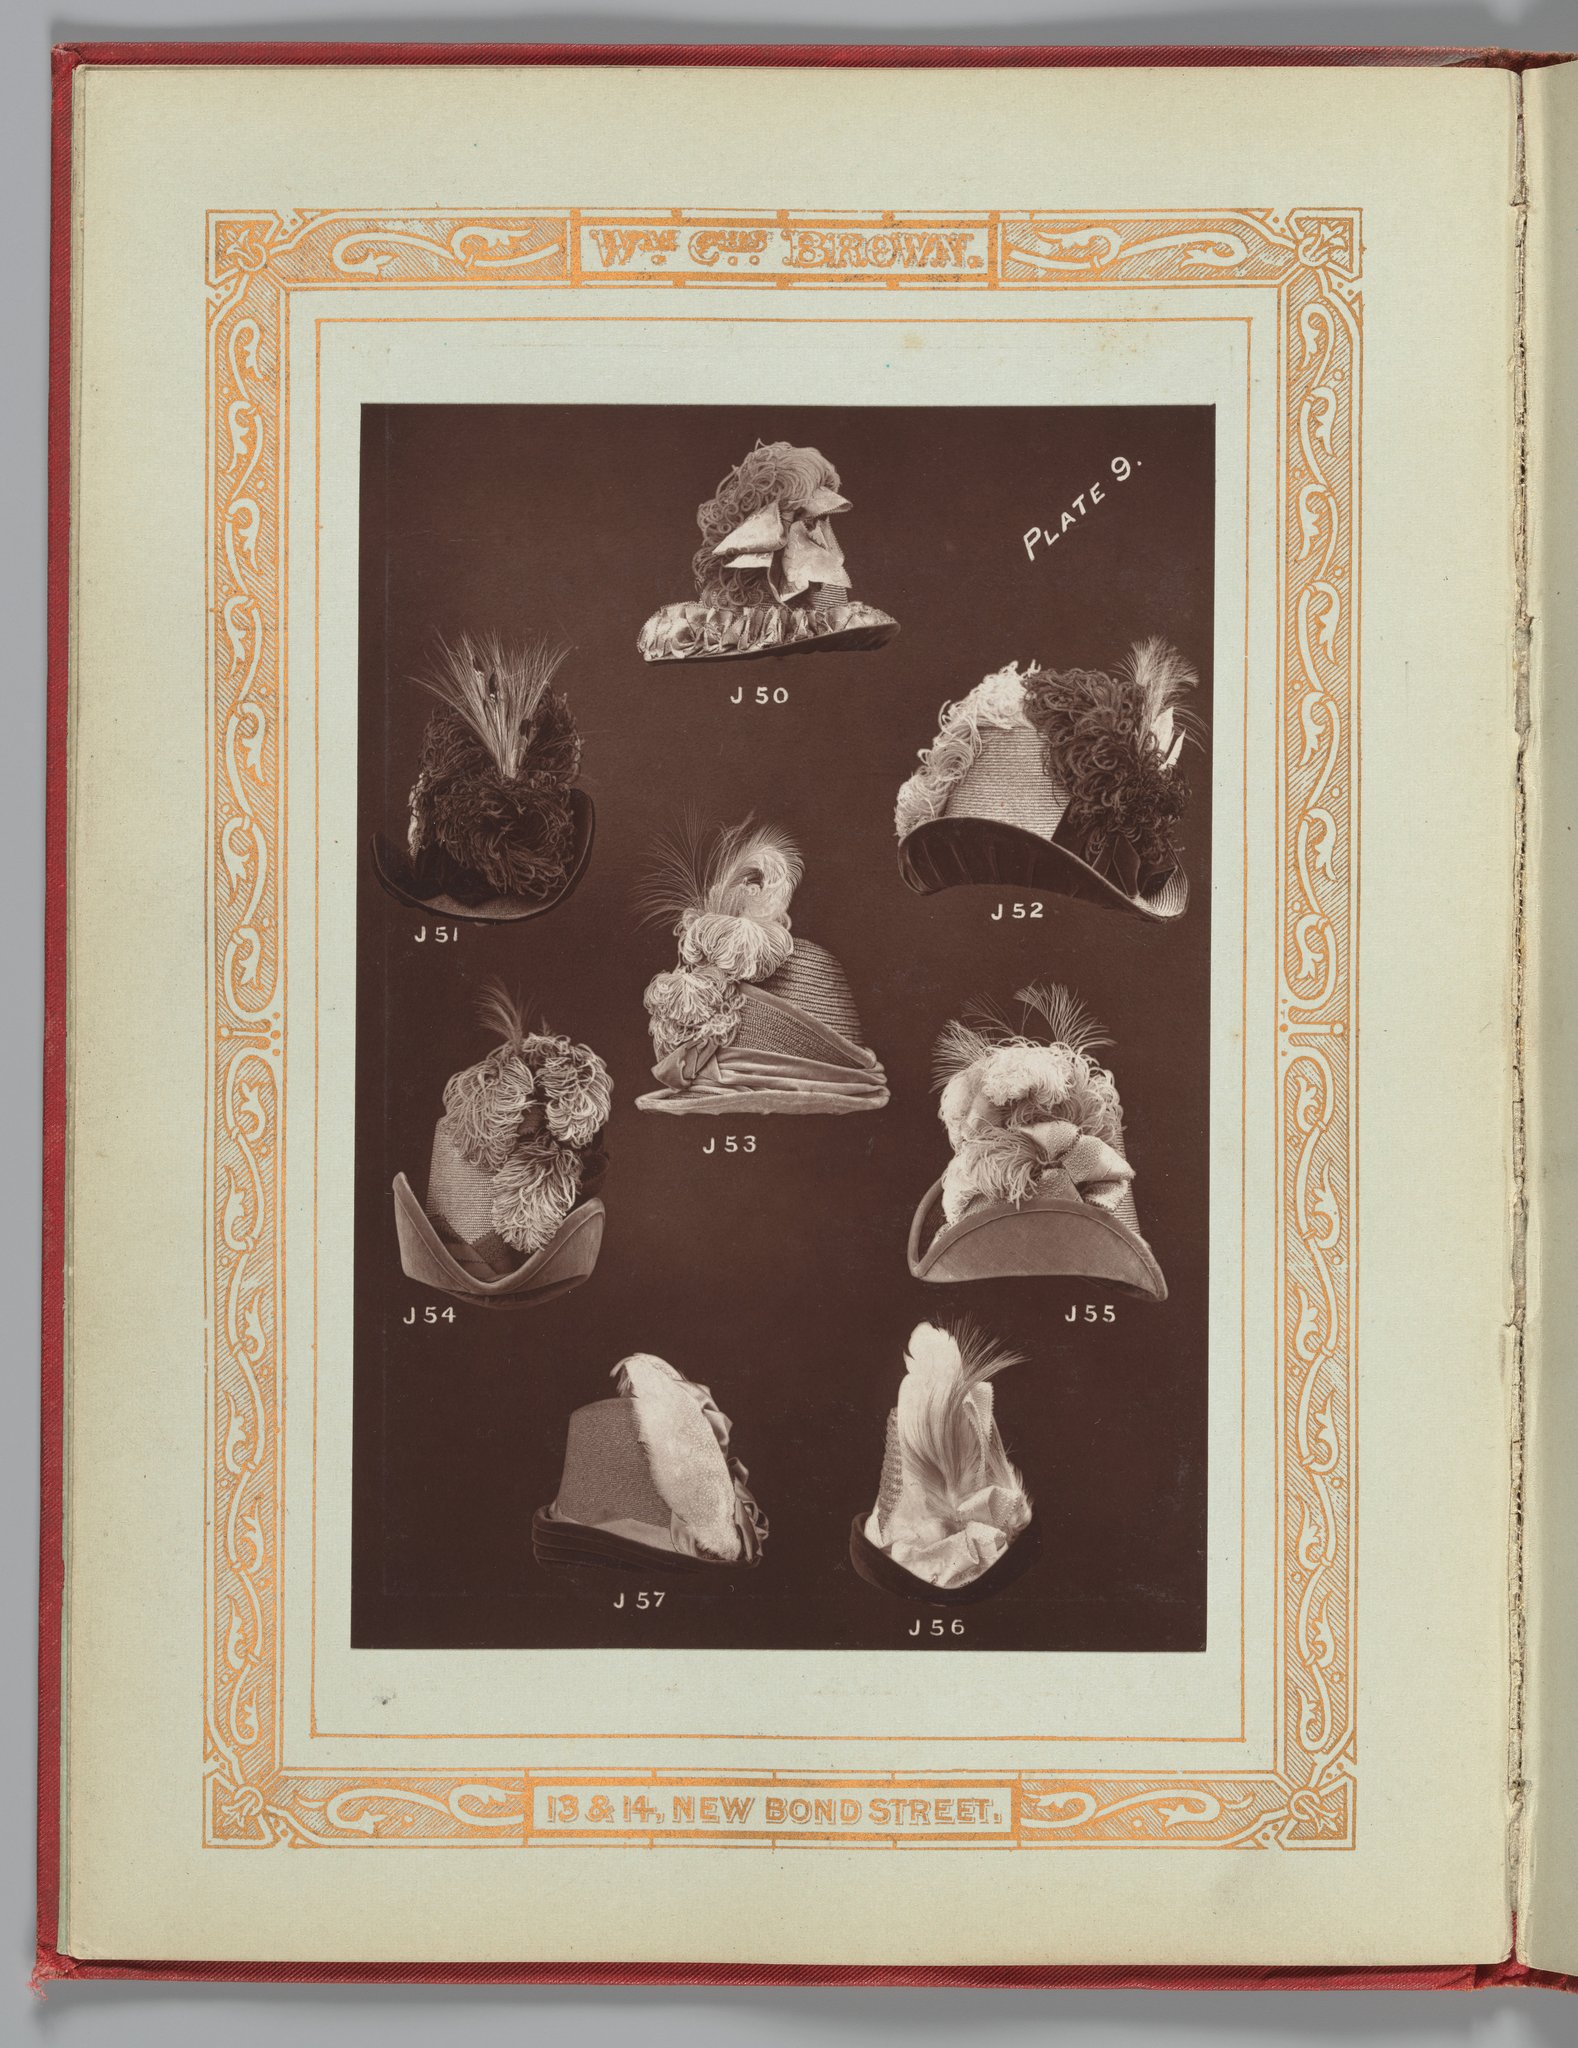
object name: photographically illustrated book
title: [Hats J50-J57]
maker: william charles brown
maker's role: author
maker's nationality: british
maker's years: 1800-1899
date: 1888